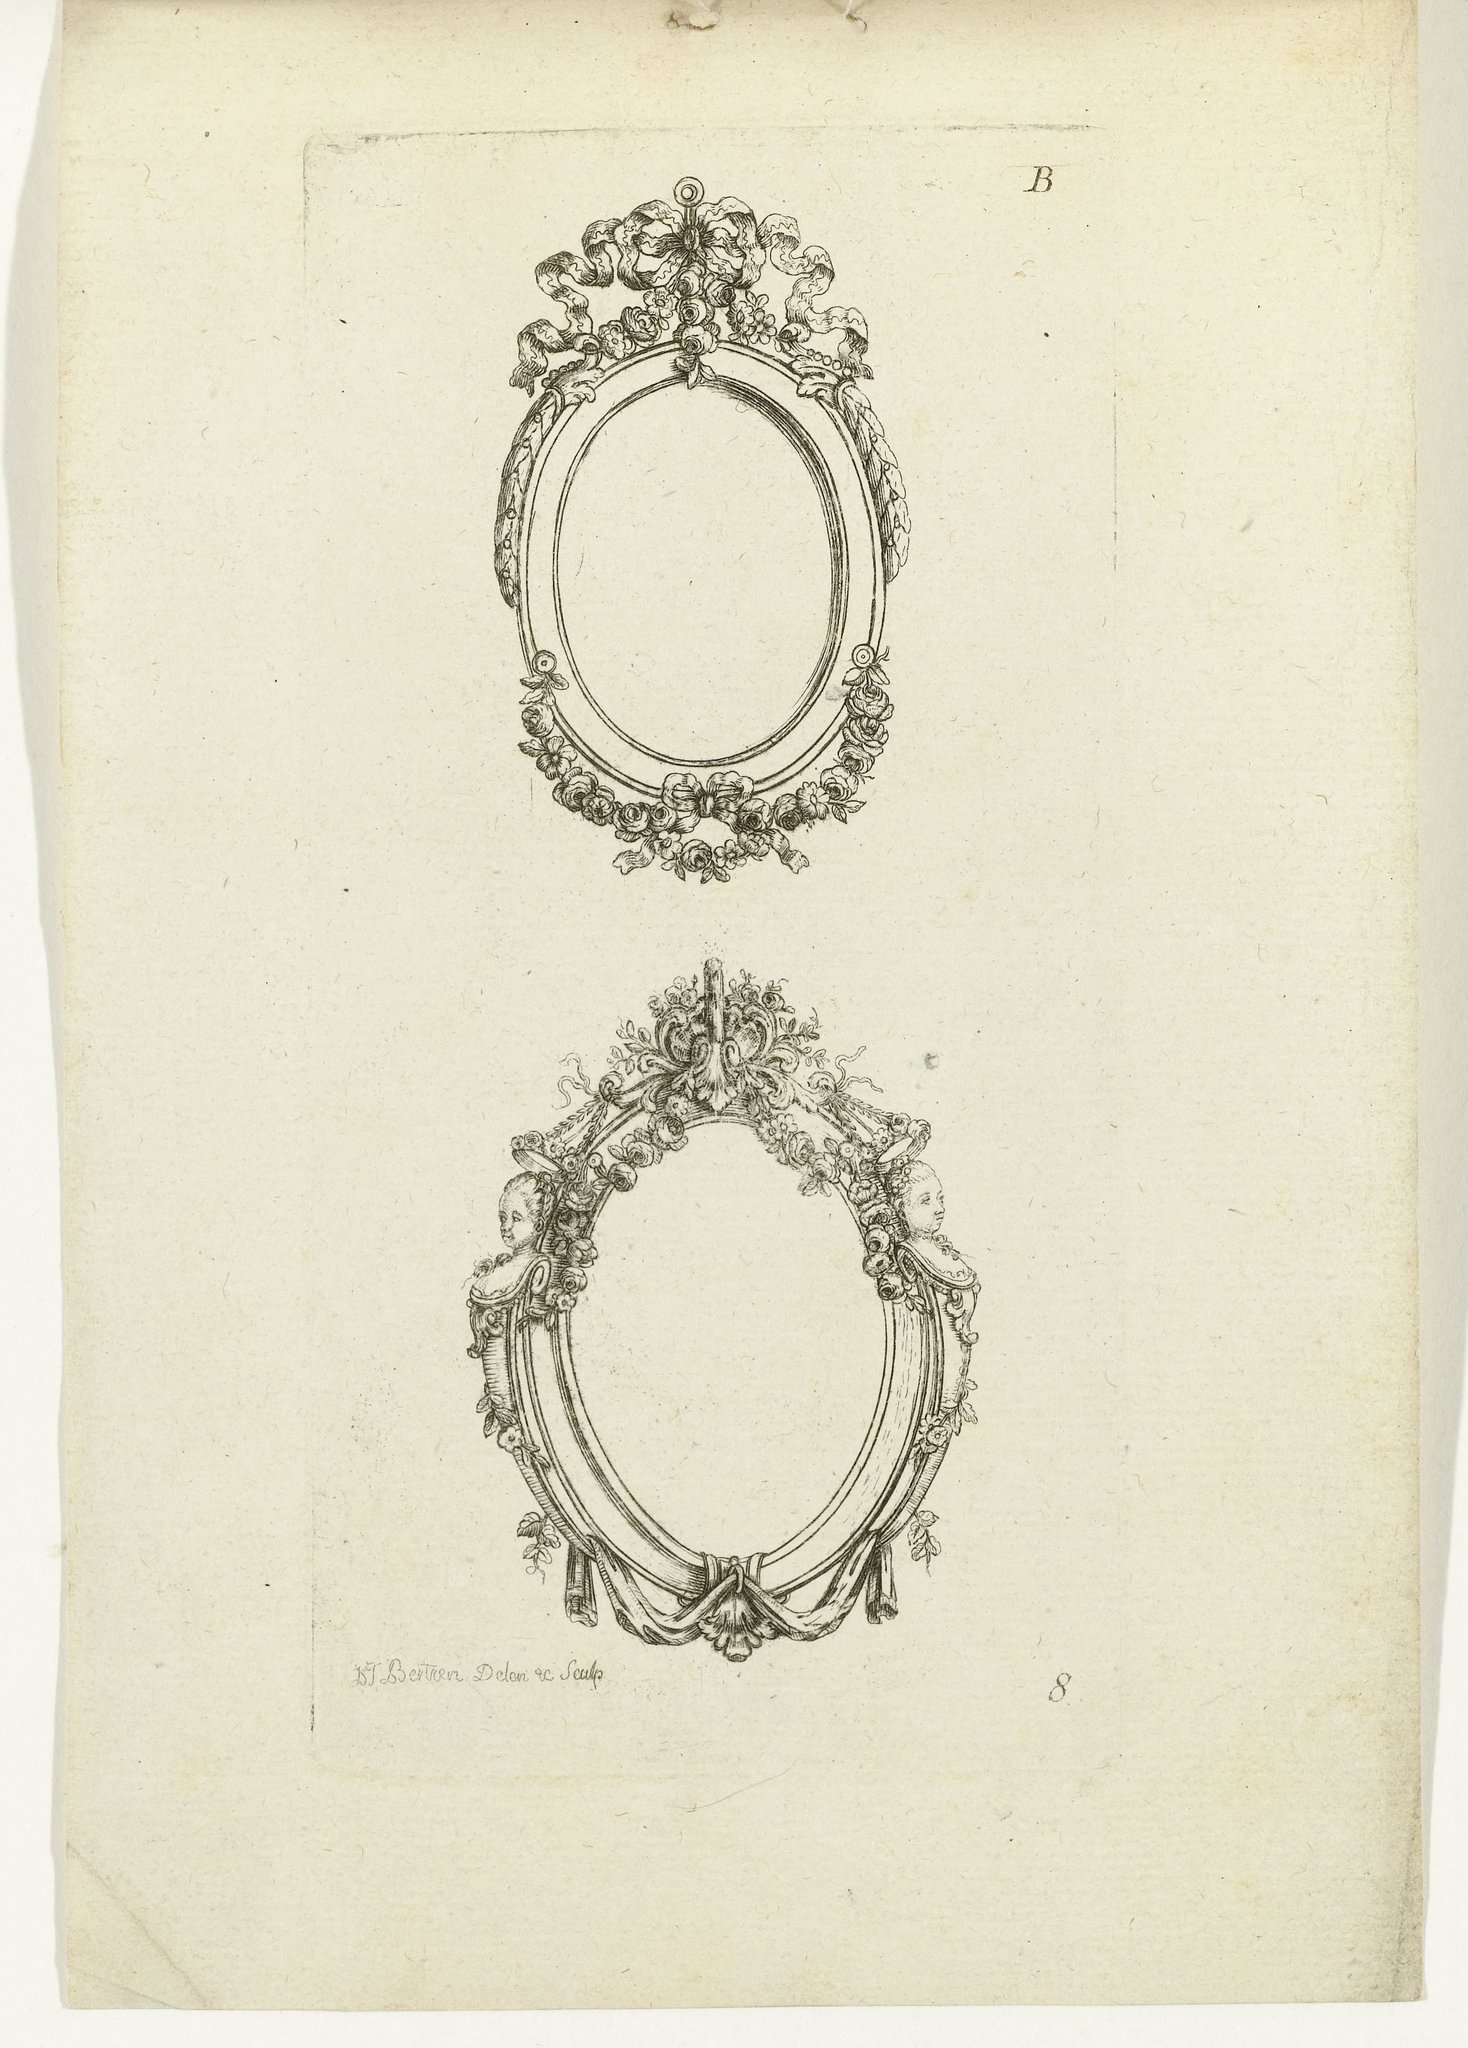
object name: ornament print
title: Twee ovale omlijstingen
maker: théodore bertren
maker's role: print maker, publisher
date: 1768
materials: paper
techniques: etching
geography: paris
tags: flowers, ornament ~ medallion, head (human) - aa - female human figure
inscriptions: collector's mark: Lugt 2228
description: De bovenste omlijsting is versierd met bloemen en een strik. De onderste omlijsting is versierd met bloemen, vrouwenbustes en rocailles. Ornamentprent uit serie B.